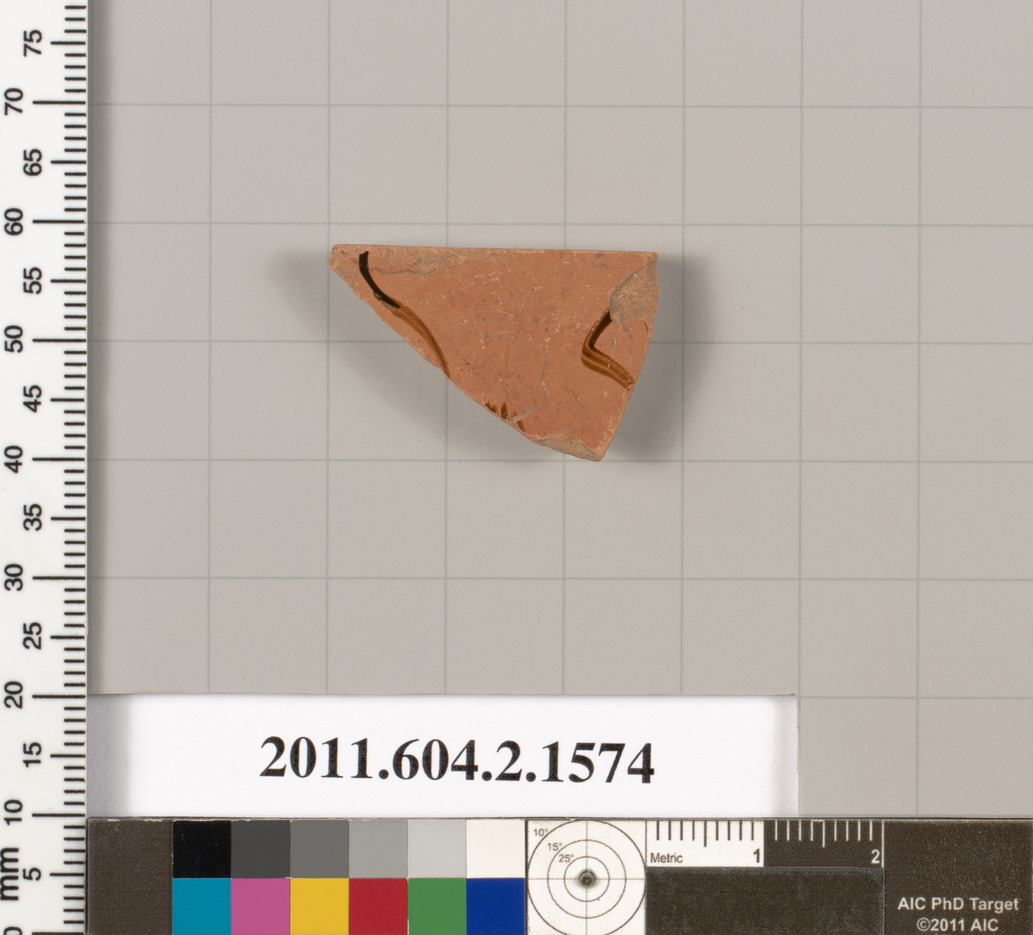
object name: skyphos fragment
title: Terracotta fragment of a skyphos (deep drinking cup)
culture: greek, attic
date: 450-401 BCE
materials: terracotta